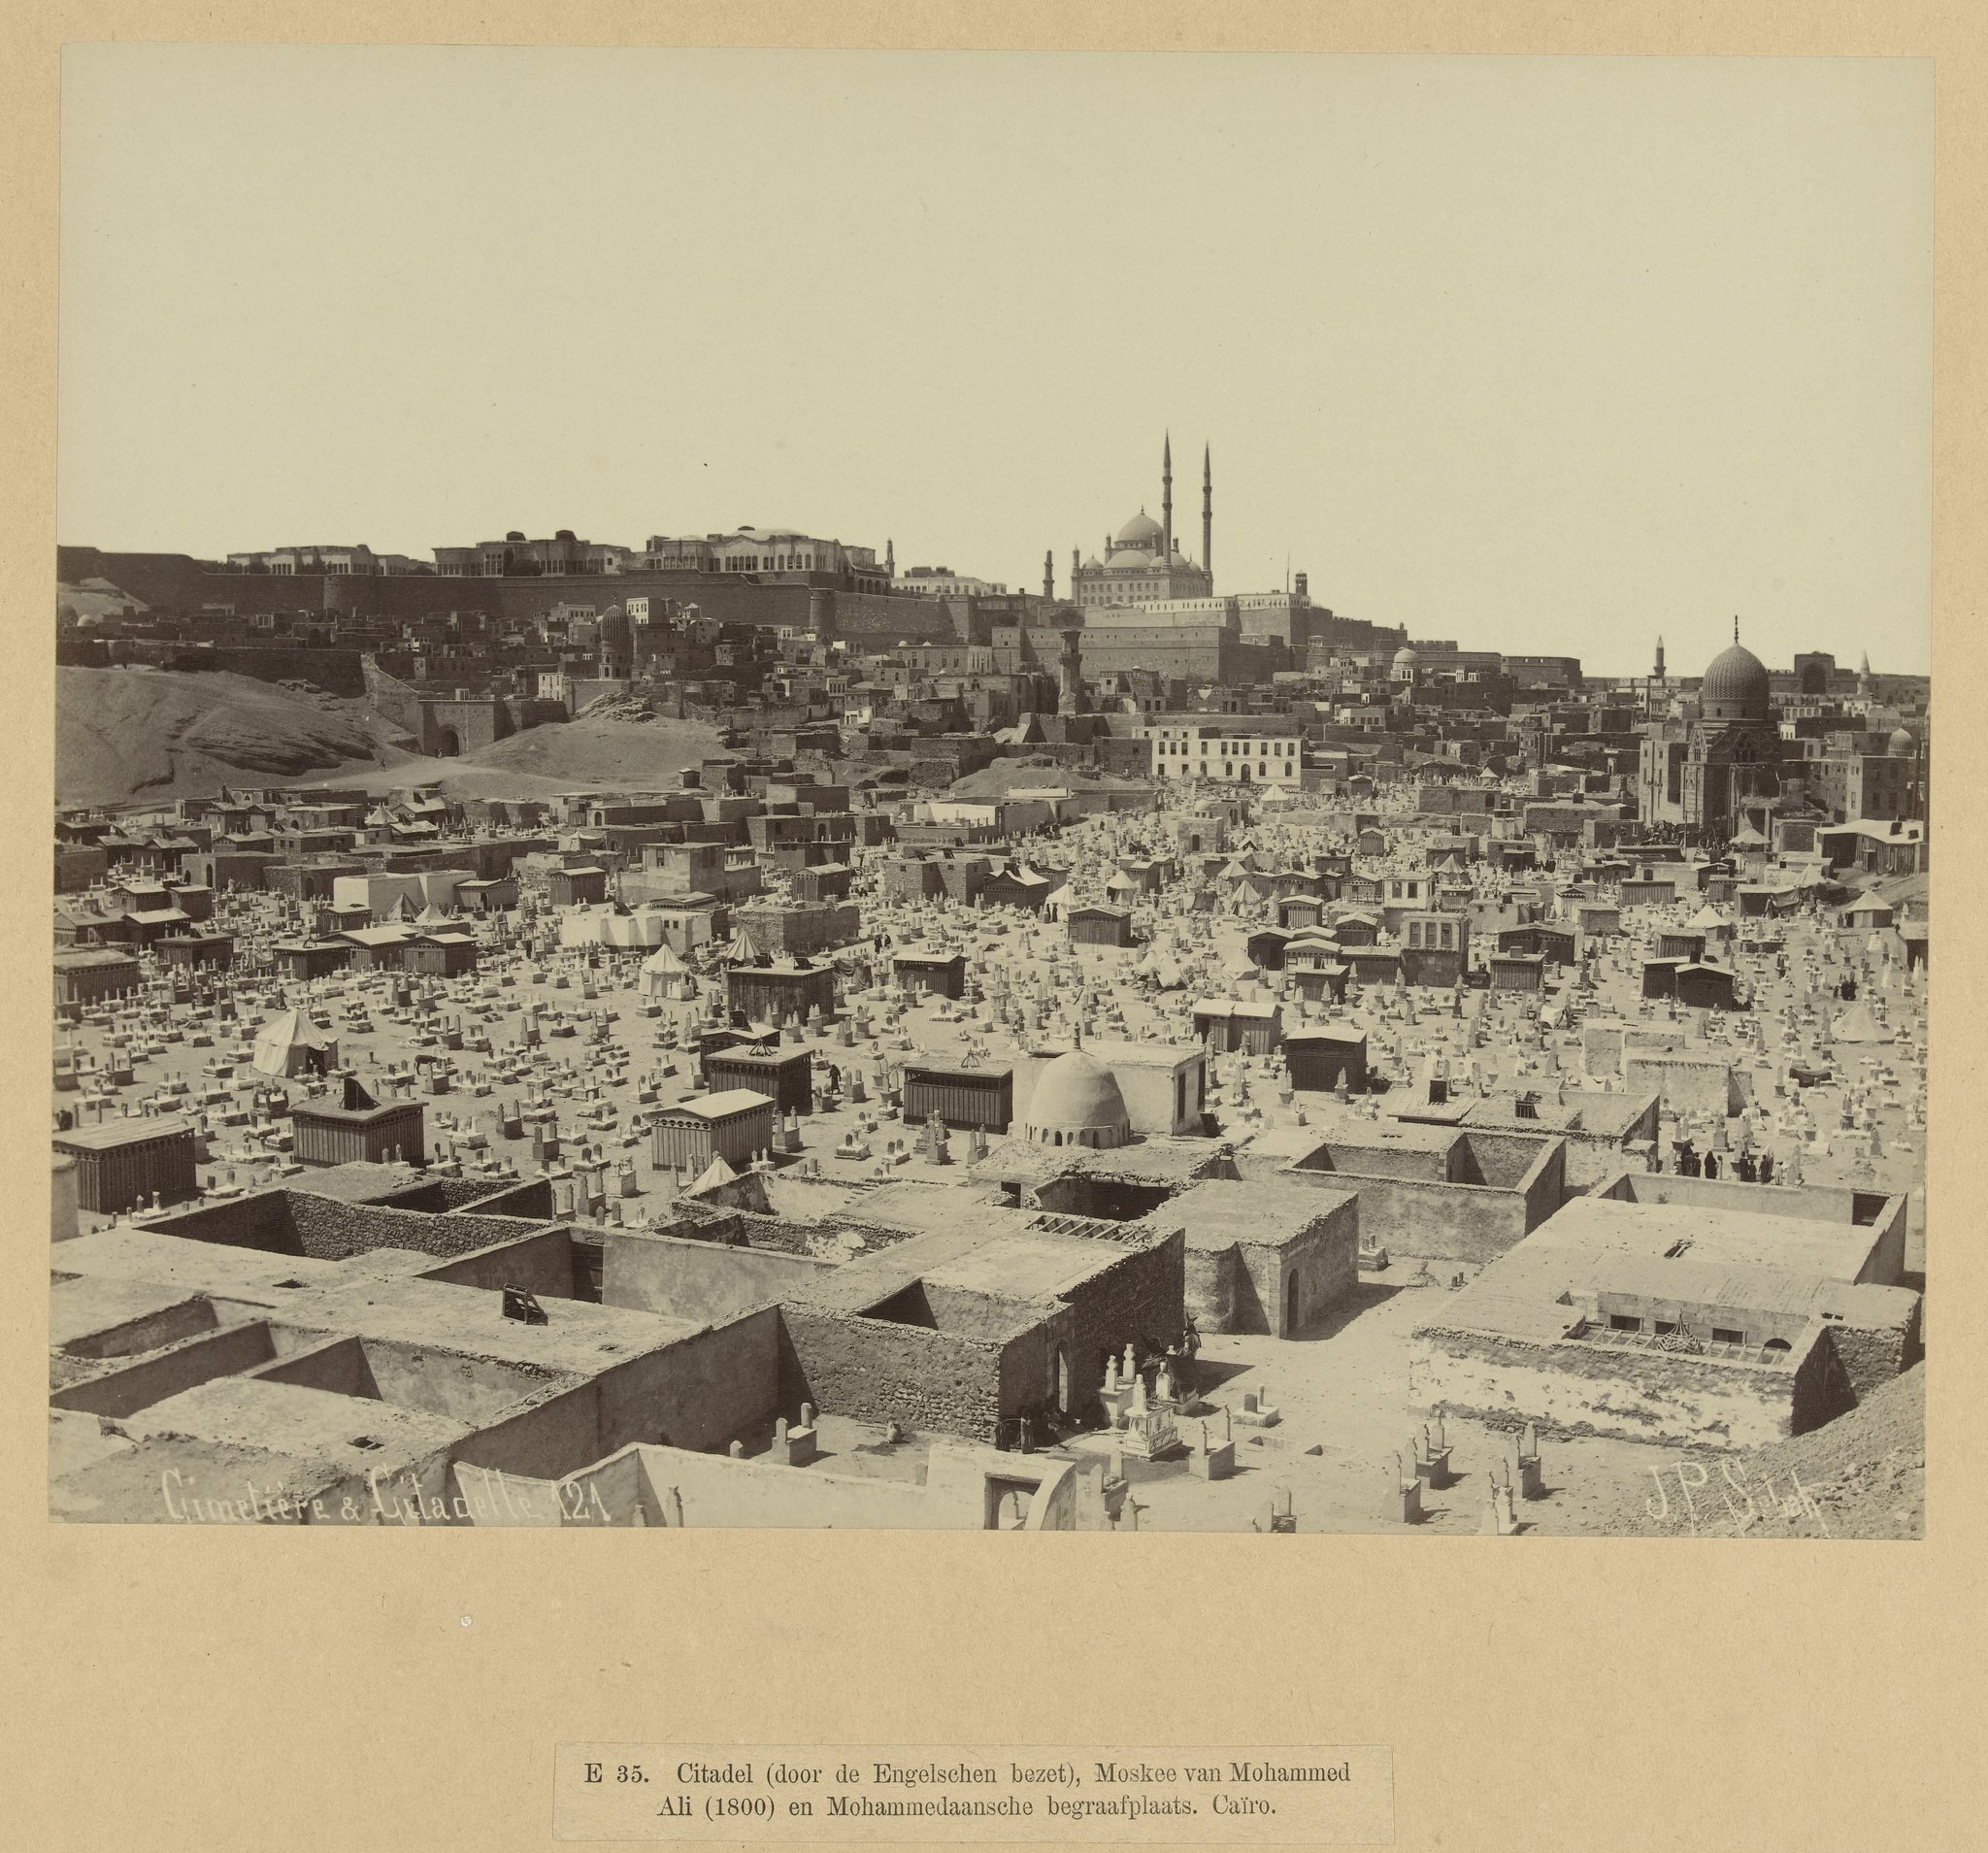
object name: photograph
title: Gezicht op de citadel van Caïro, met op de voorgrond een begraafplaats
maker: jean pascal sébah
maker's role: fotograaf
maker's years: 1872-1947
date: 1888-1895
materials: cardboard, paper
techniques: albumen print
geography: cairo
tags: temple, shrine ~ islam, mohammedanism, churchyard, cemetery, fortified city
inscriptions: title: ‘E 35. Citadel (door de Engelschen bezet), Moskee van Mohammed/ Ali (1800) en Mohammedaansche begraafplaats. Caïro.’, stamp: ‘Gemeentelijke bibliotheek/ Rotterdam’, check stamp: ‘Bristol/ L.M.’, number: ‘121’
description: Onderdeel van een groep door fotograaf Richard Polak op reis verzamelde foto’s. Deze foto is samen met andere op zijn reizen verzamelde foto's tentoongesteld bij de Rotterdamsche Kunstkring (1895), Arti en Amicitiae te Amsterdam (1897-1898?) en Societeit 't Collegie te Kampen (datum vooralsnog onbekend).